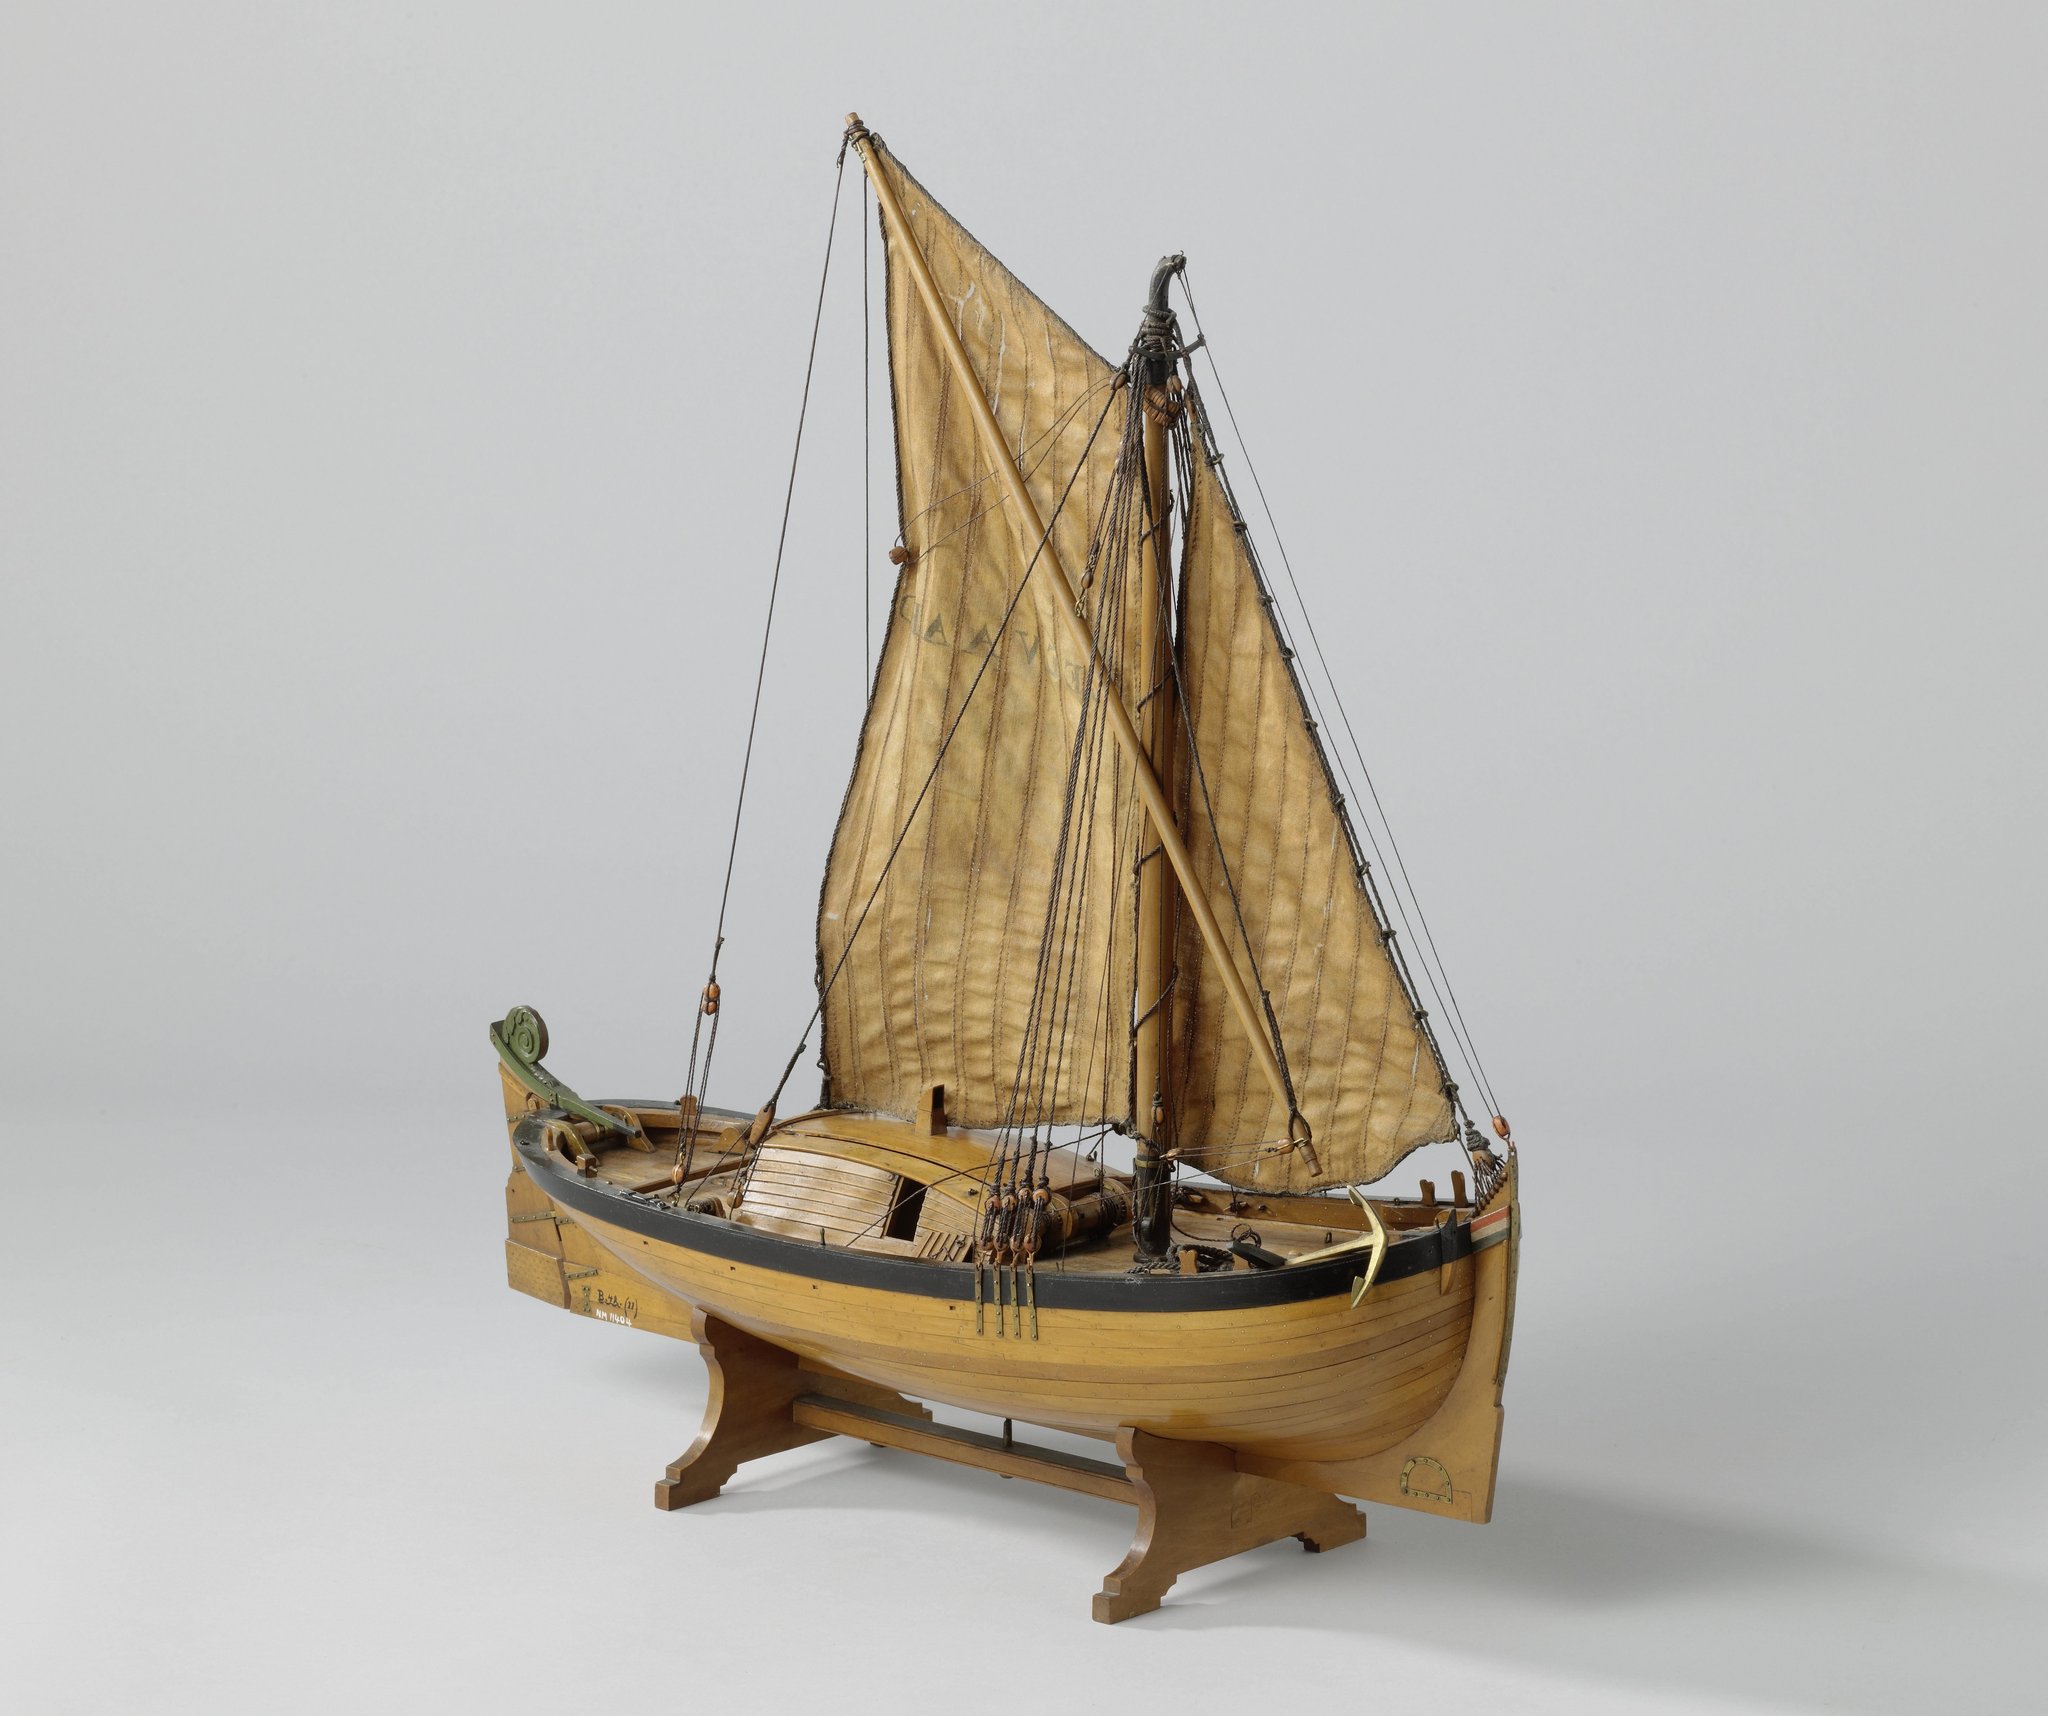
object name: ship model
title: Model of a Marker Waterschip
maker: Anonymous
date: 1800-1850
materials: copper, paint, fiber, textile, wood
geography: netherlands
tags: ship-model (+ propulsion of vehicle, ship, etc. by wind), zuiderzee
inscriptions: : ‘ZEEVAARD’